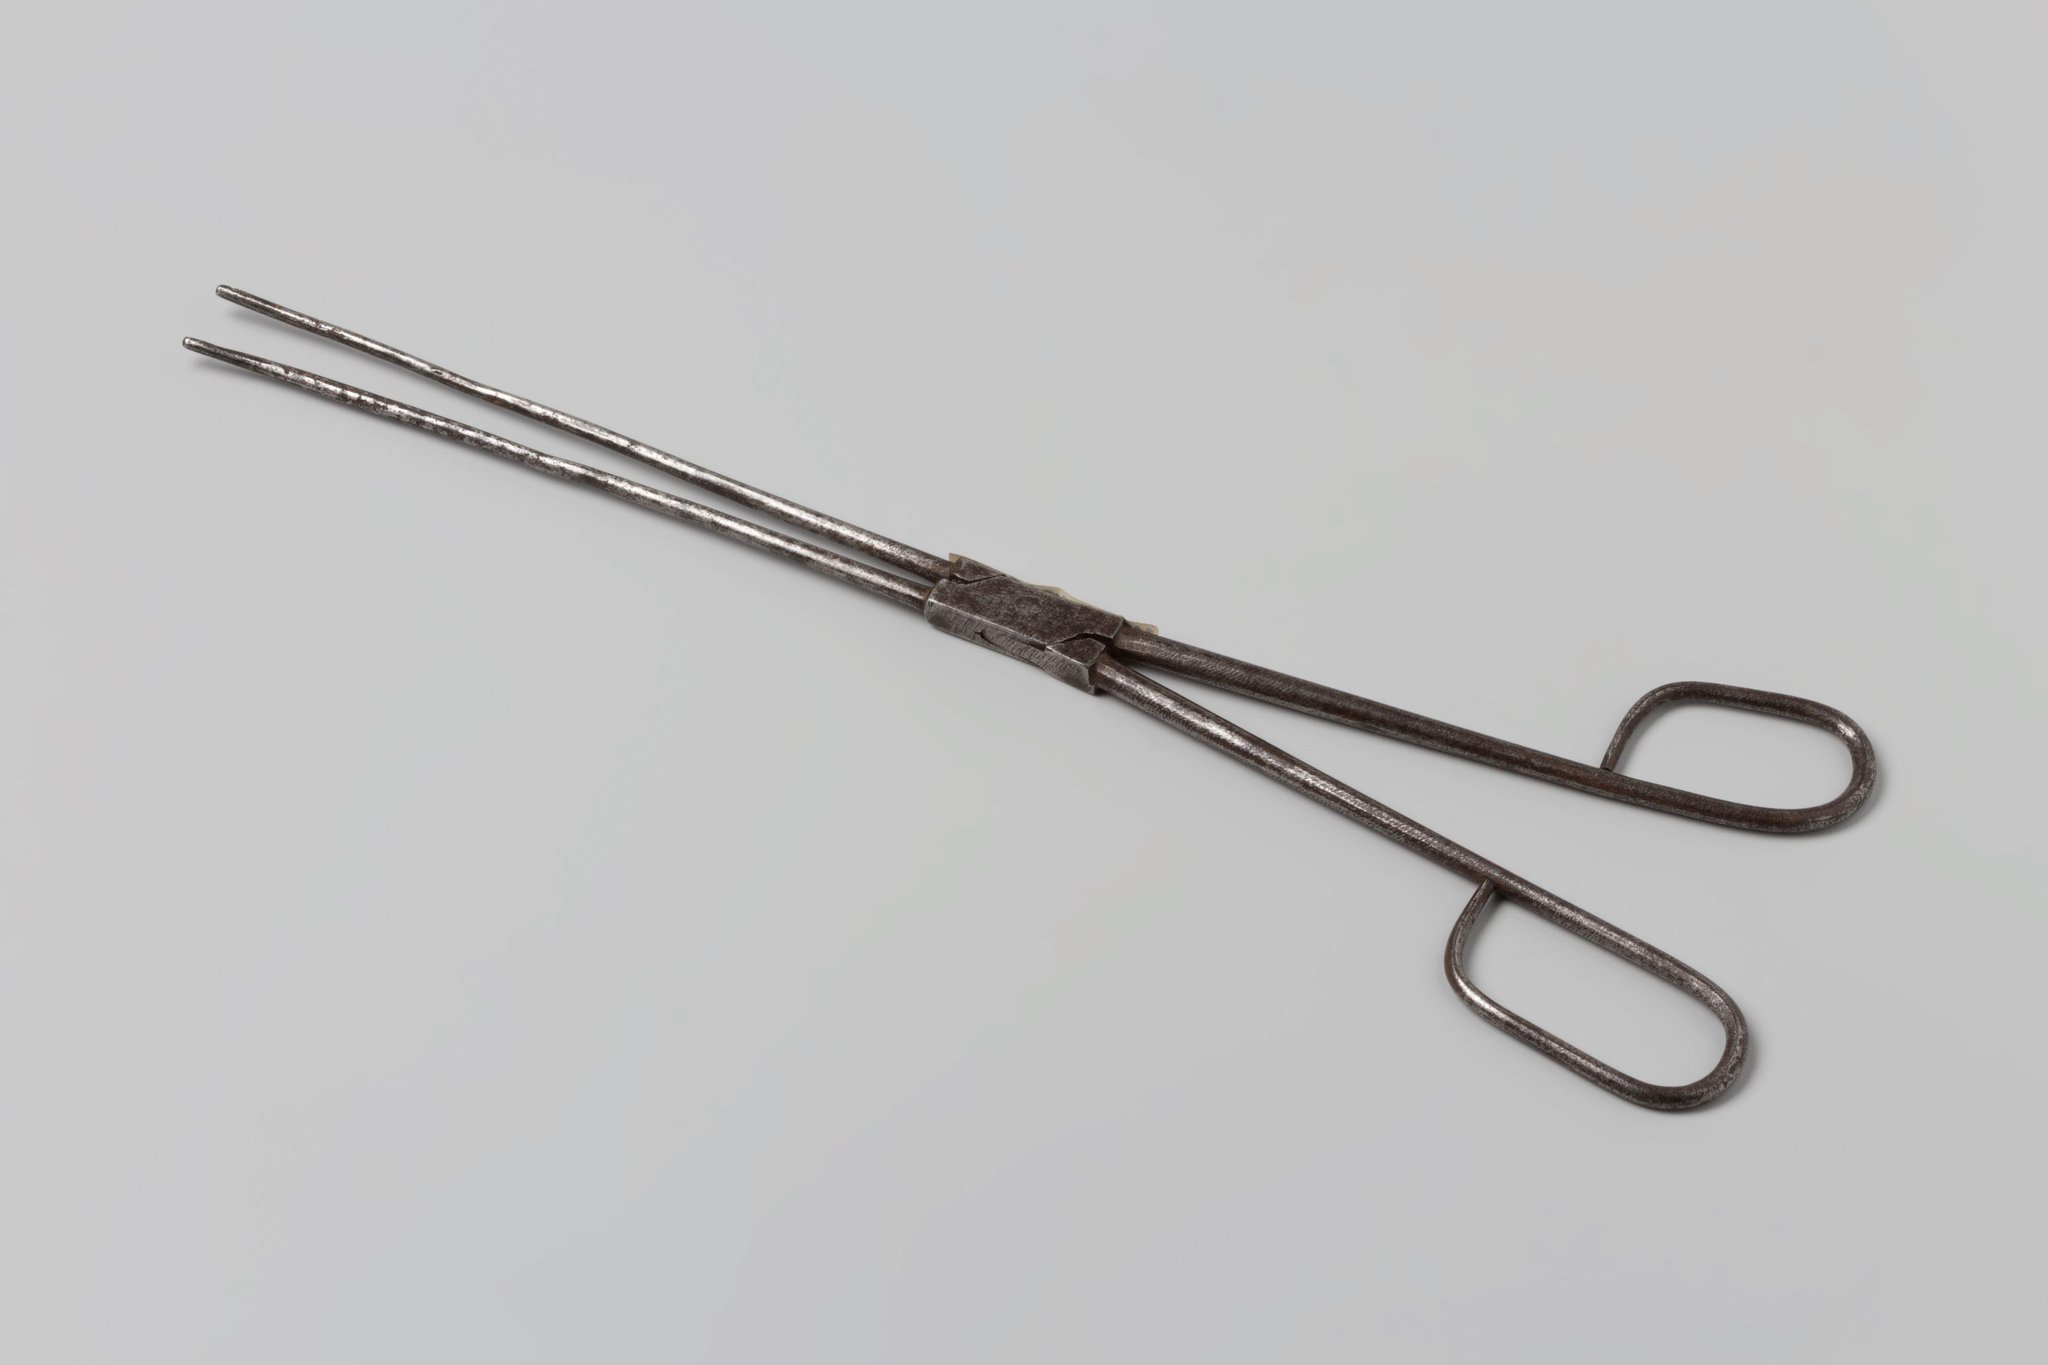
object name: tool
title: Neepjesmutstang van ijzer, in het model van een schaar, voor de plooien in een neepmuts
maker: Anonymous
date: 1800-1900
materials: iron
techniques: forging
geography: netherlands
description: Een neepjesmutstang van ijzer. In het model van een schaar met rechthoekige gebogen ogen en twee dunne rolronde tangen.